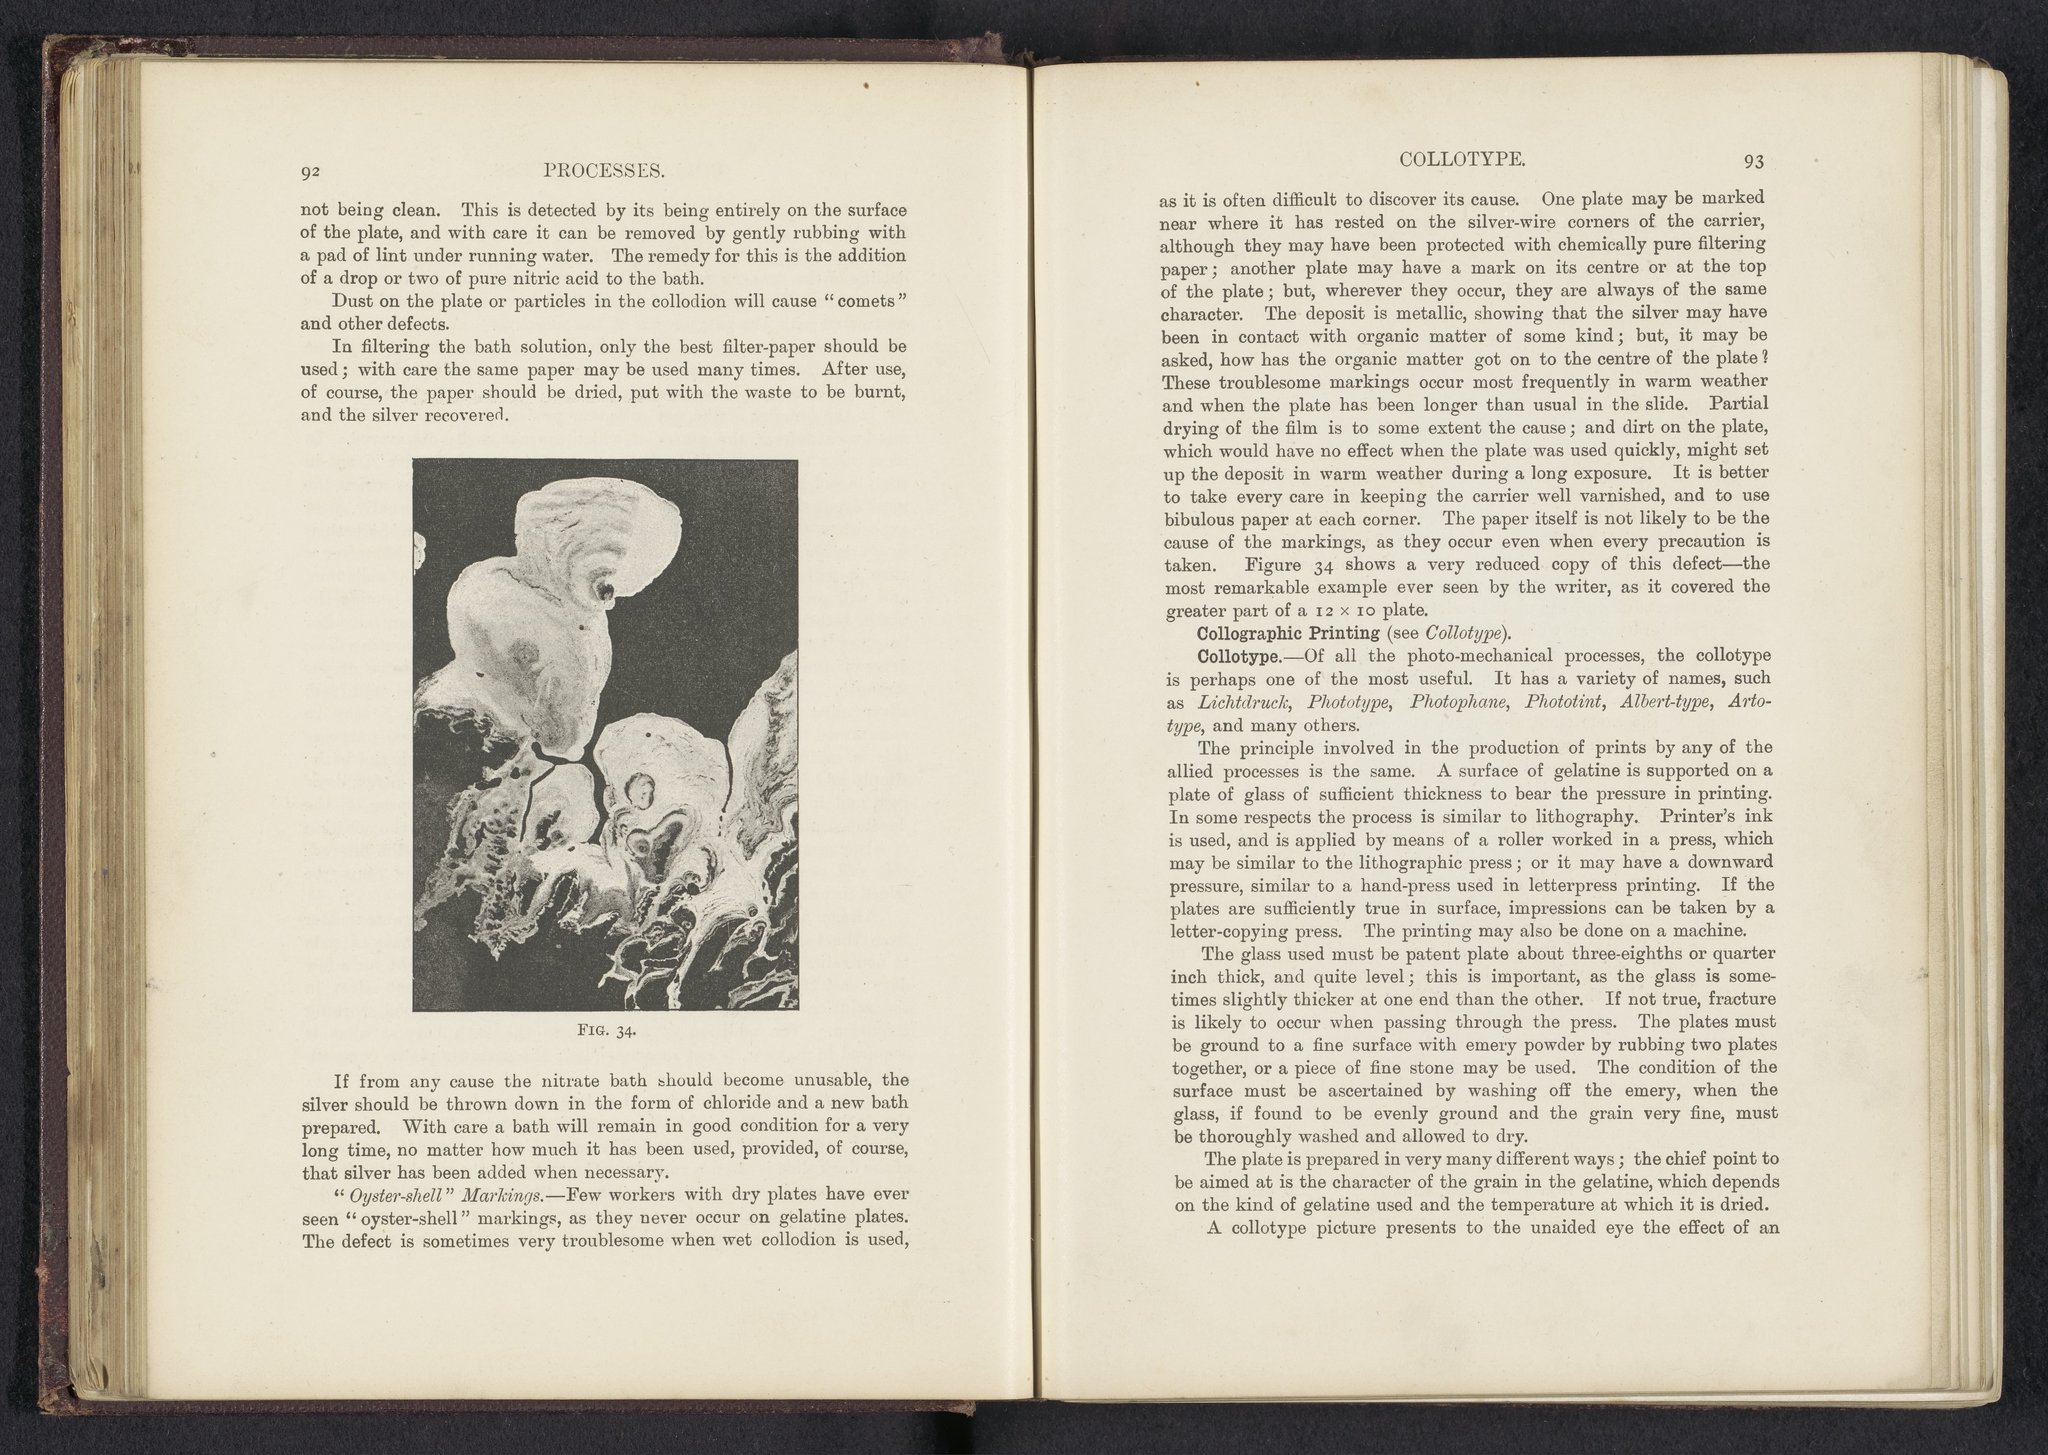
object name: page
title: Vlekken op een natte collodiumplaat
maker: Anonymous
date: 1889-1899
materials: paper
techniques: autotype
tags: plate, film ~ photography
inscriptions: number: ‘Fig. 34.’